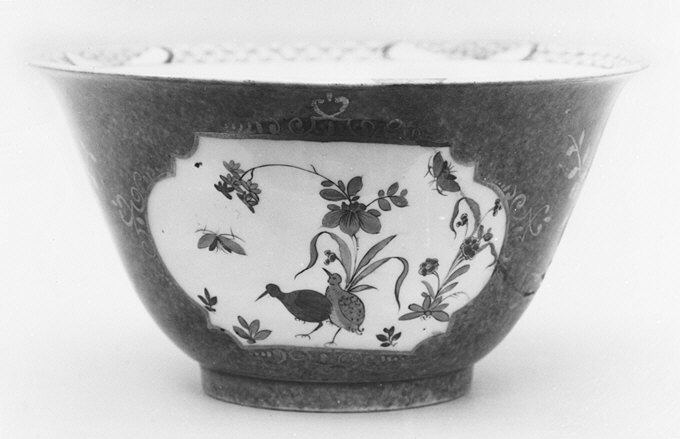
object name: bowl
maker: meissen manufactory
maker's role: manufactory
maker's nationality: german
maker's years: 1710-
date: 1728-1730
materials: hard paste porcelain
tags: birds,flowers